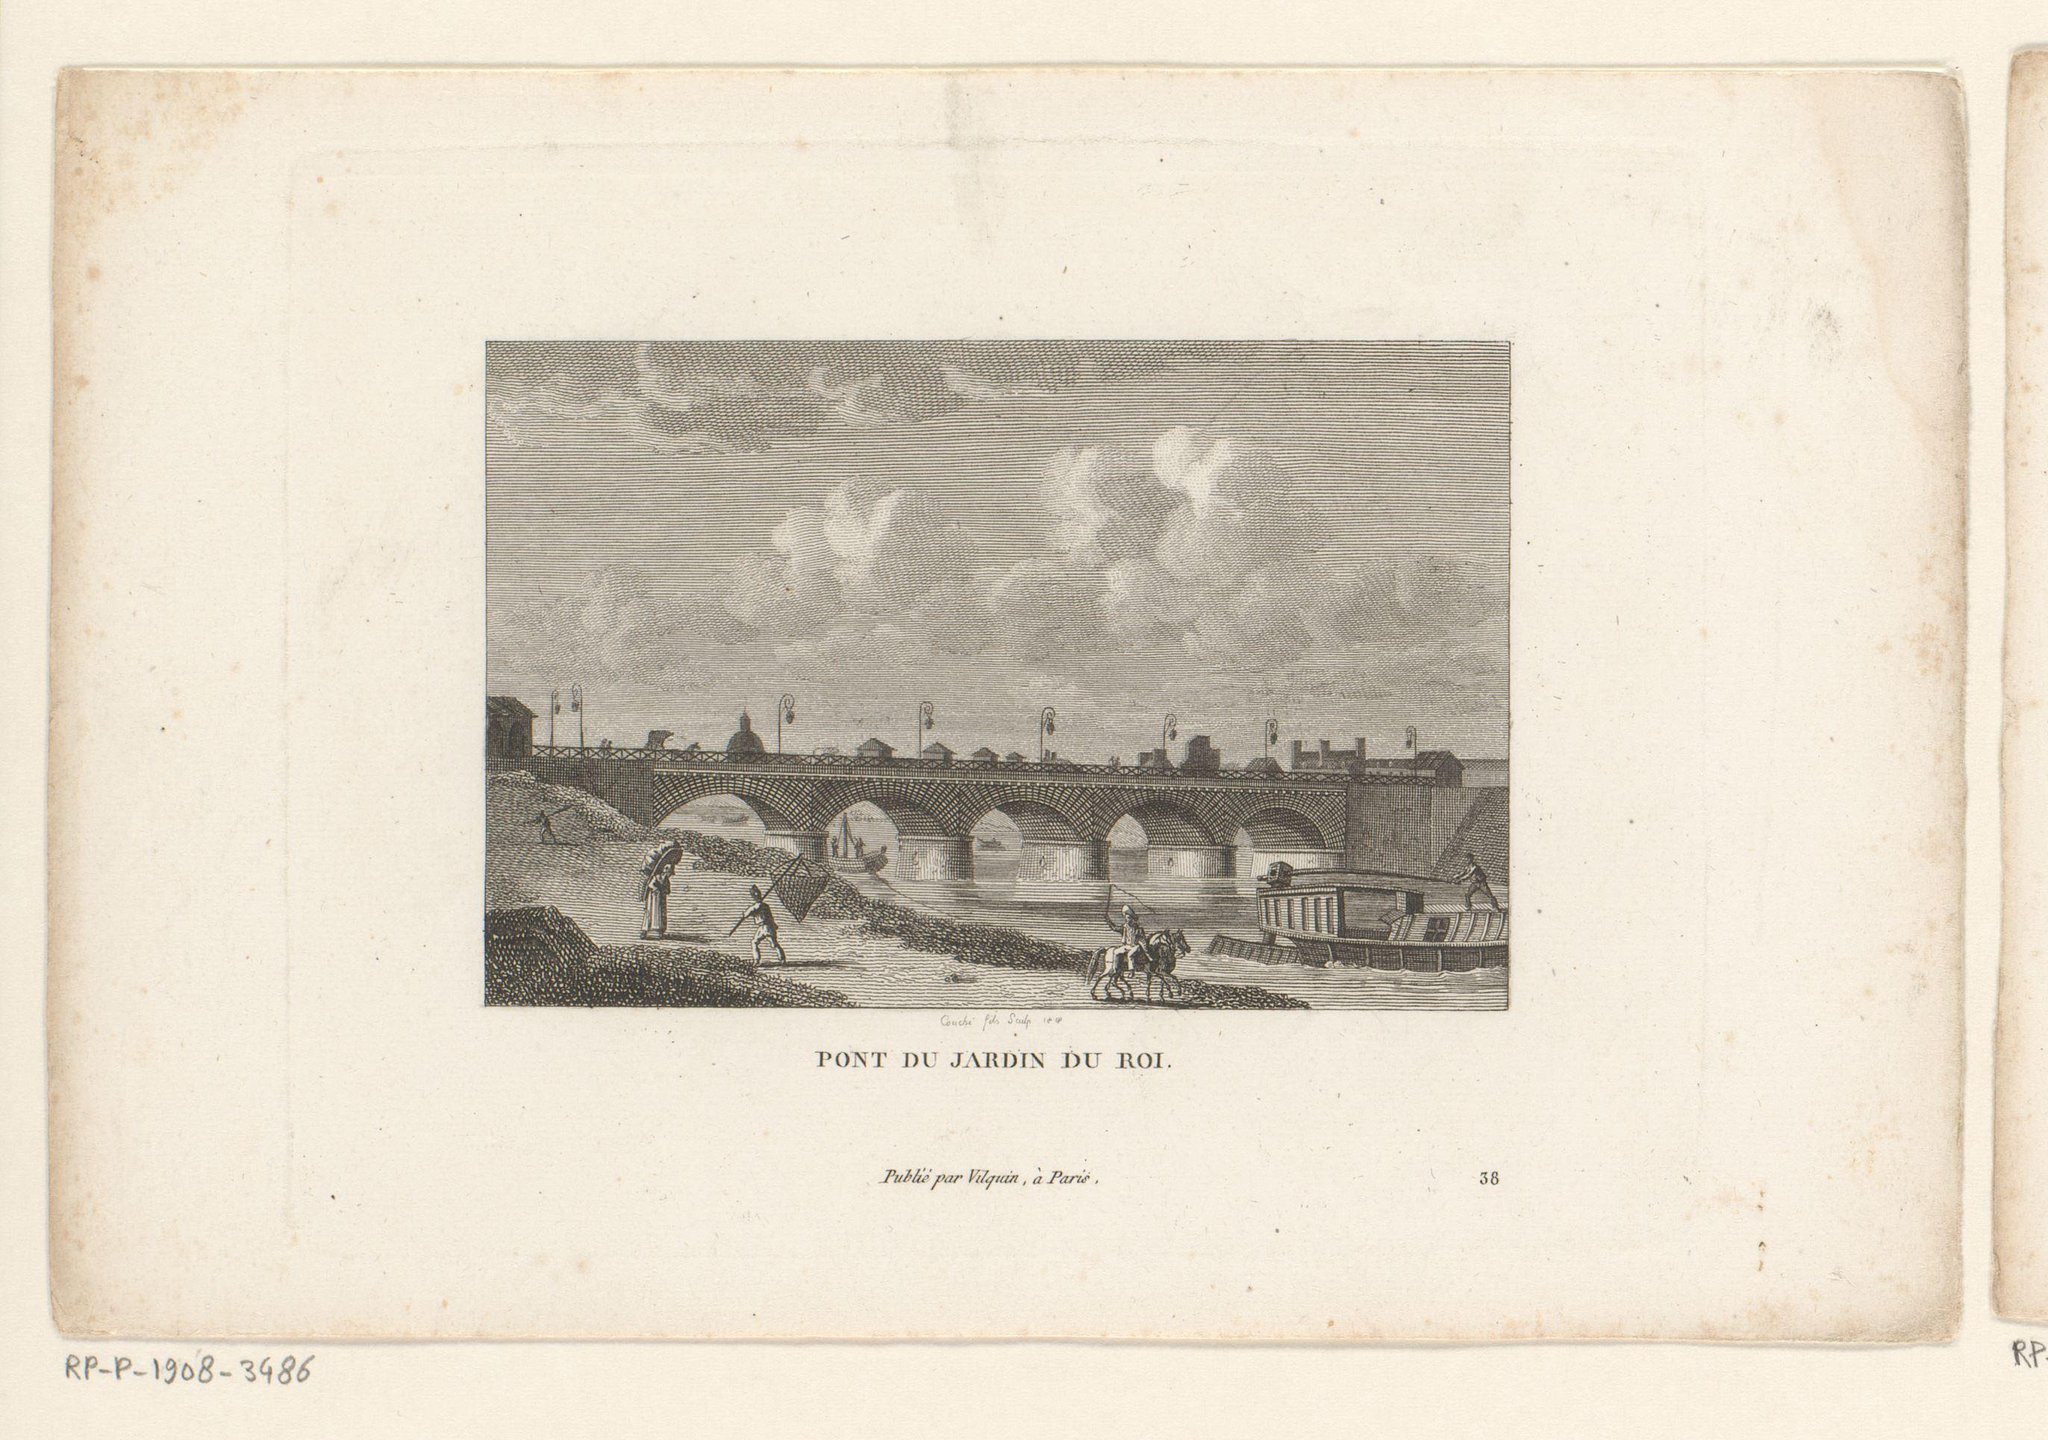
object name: print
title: Gezicht op de pont du Jardin du Roi te Parijs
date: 1818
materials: paper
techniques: etching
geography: paris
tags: city-view in general; 'veduta', bridge, paris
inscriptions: collector's mark: Lugt 2228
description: Maakt deel uit van een serie met 60 platen van monumenten, kathedralen en paleizen in Parijs.